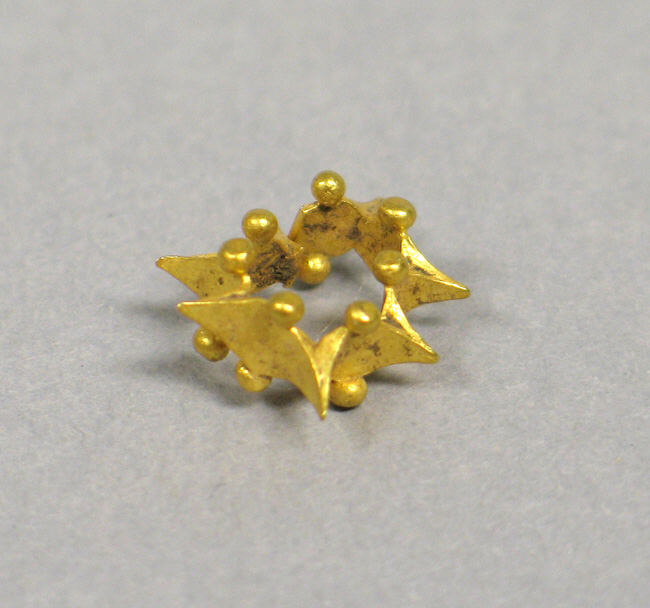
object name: ear clip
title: Pair of Ear Clips of Alternating Spires and Beads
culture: indonesian, javanese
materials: gold